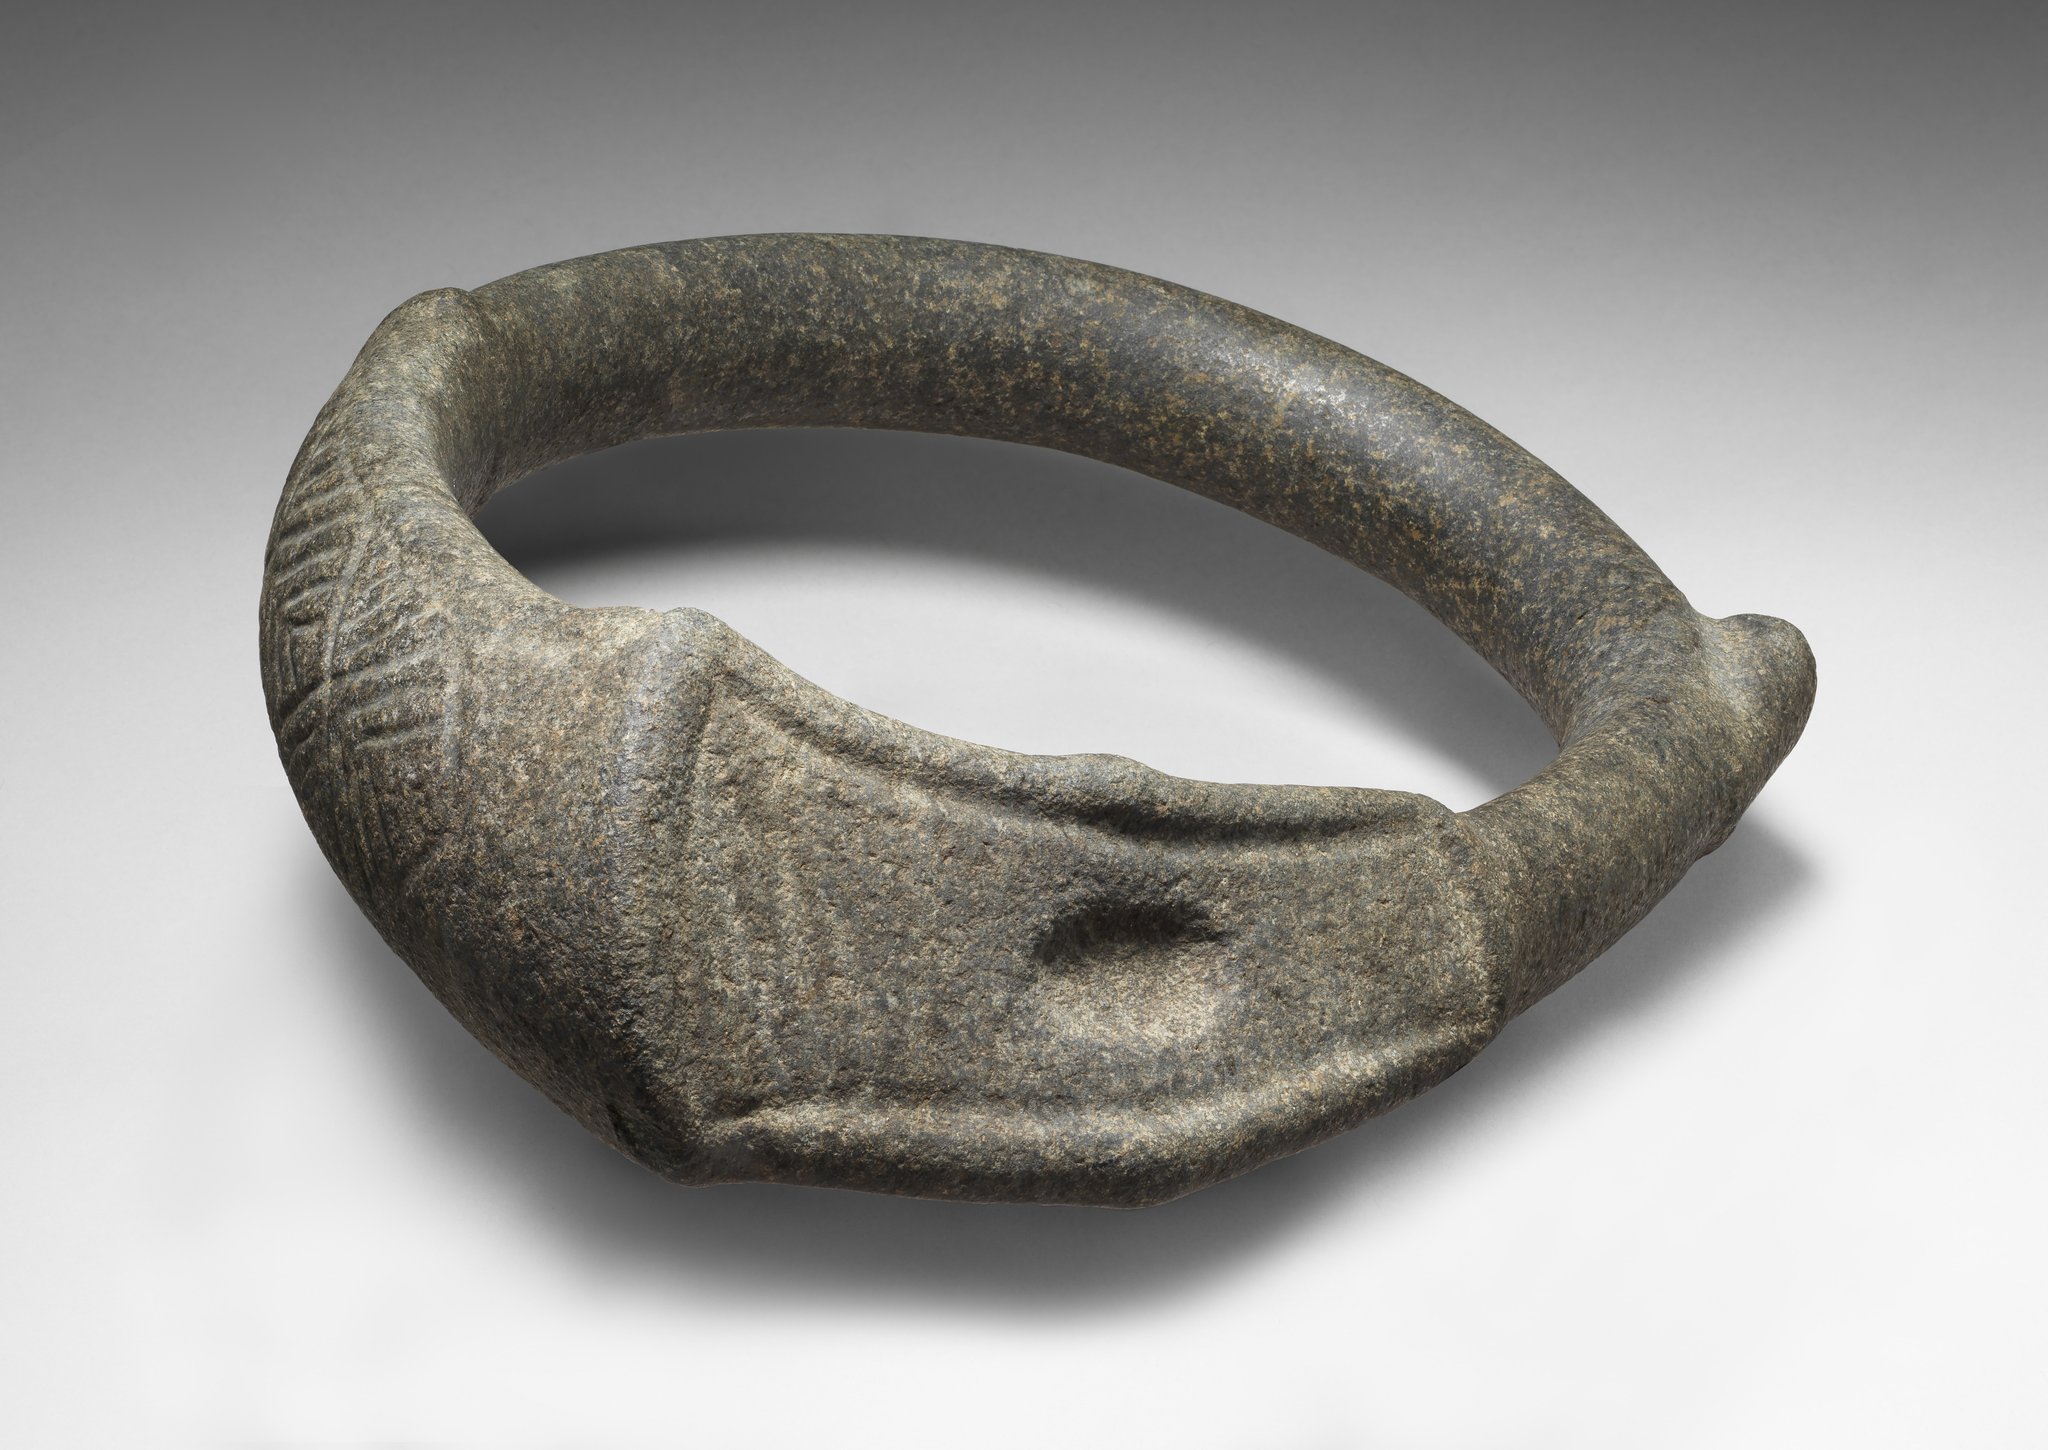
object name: collar or belt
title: Ceremonial collar or belt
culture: taíno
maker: taíno artist(s)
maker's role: artist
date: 1000-1495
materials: stone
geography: united states